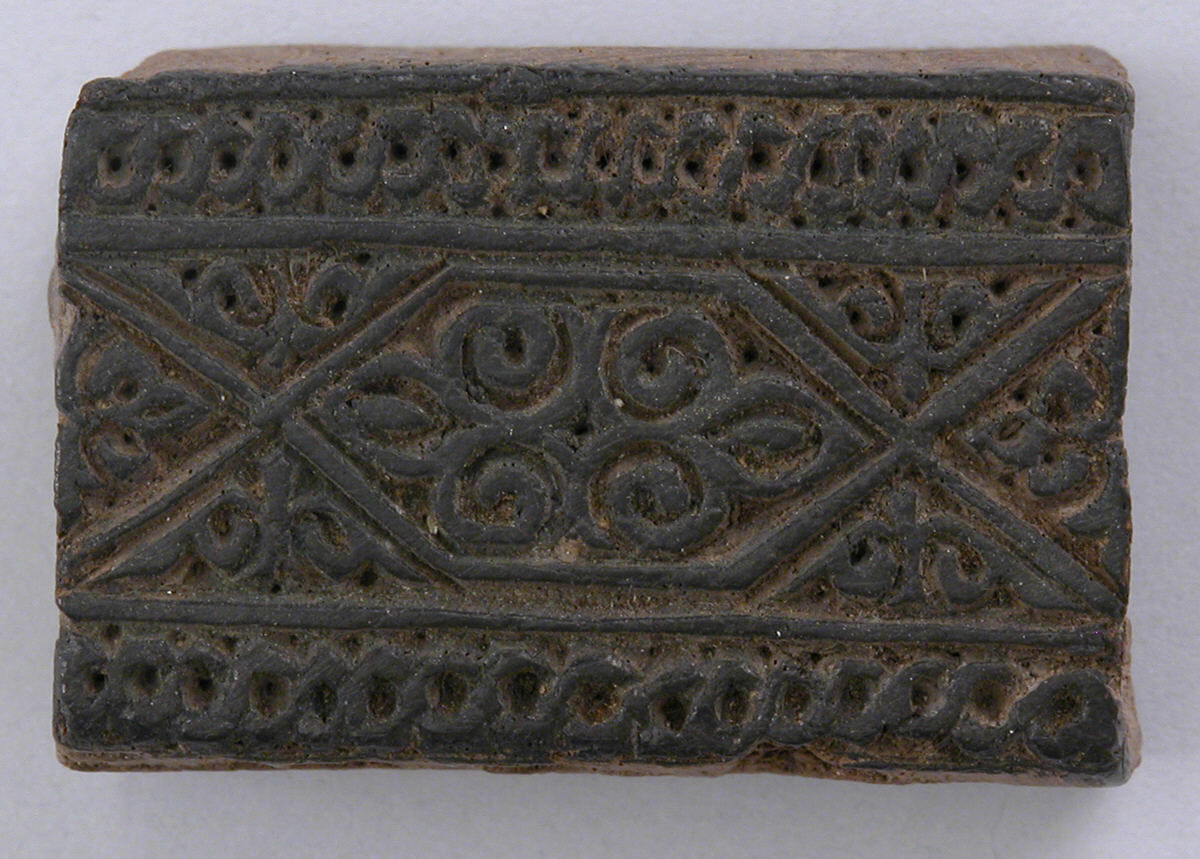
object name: printing block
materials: wood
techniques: carving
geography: egypt